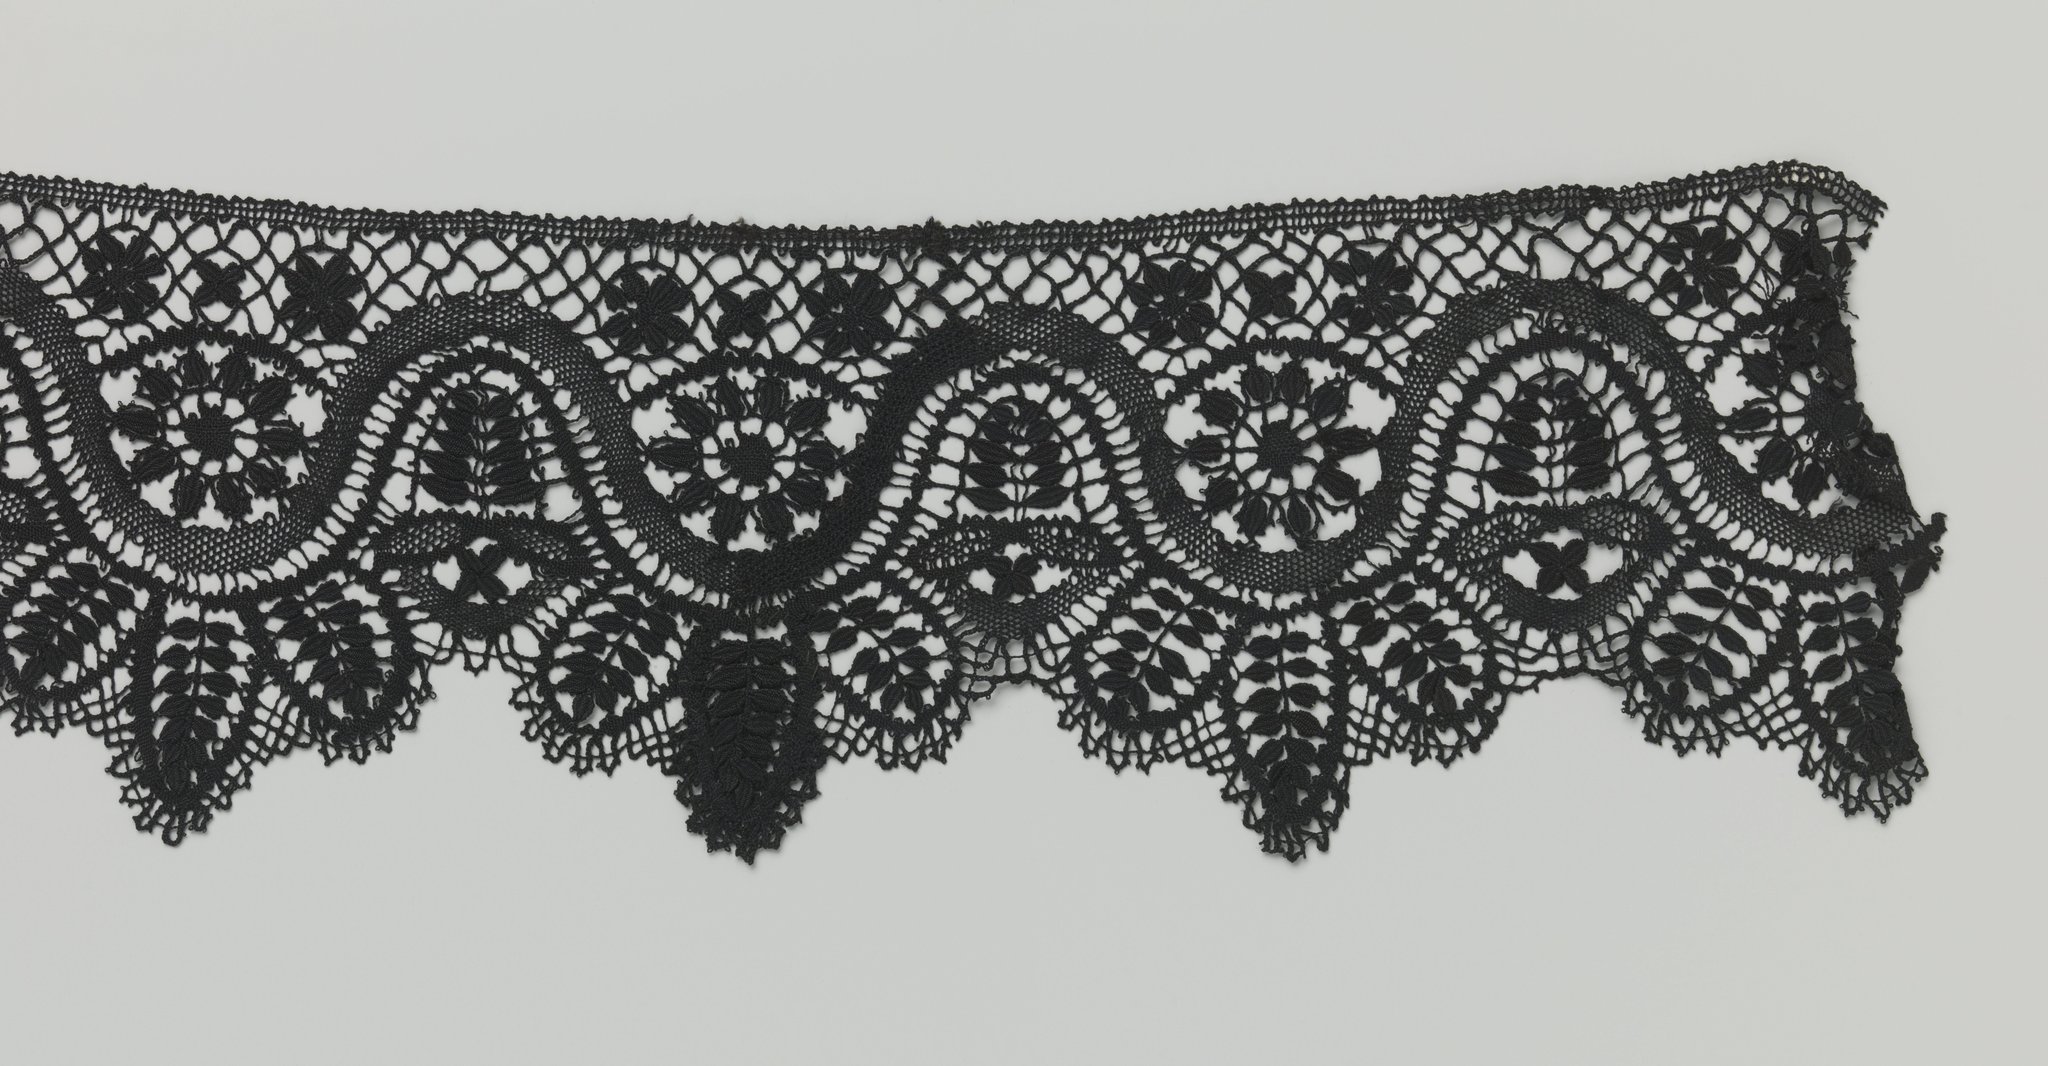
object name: strip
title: Strook kloskant met diepe golflijn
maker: Anonymous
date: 1880-1899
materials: silk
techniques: lace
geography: geraardsbergen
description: Strook zwarte kloskant, Cluny-kant. Het zich herhalende en symmetrische patroon bestaat uit een diepe golflijn. In elk golfdal staat een rozet met daarboven twee kleinere rozetten en een vierpuntig sterretje ertussen. Elke golftop omvat een samengesteld, staand blad, met aan weerszijden vijf blaadjes. Onder het blad staat een omlijst vierpuntig sterretje. De schulpenrand langs de onderzijde van de strook wordt gevormd door drie uitstralende lobben onder elk golfdal. In elk van deze lobben hangt een samengesteld blad naar beneden. De lobben zijn afgewerkt met boogjes gemaakt met gepicoteerde vlechtjes. De golflijnen en omlijstingen zijn gemaakt in netslag en linnenslag, de rozetblaadjes, samengestelde bladeren en sterren in vormslag. Ze zijn met elkaar verbonden door een vlechtengrond, die een grove vierkante tralie vormt aan de bovenzijde van de strook. De bovenzijde van de strook is recht afgewerkt.